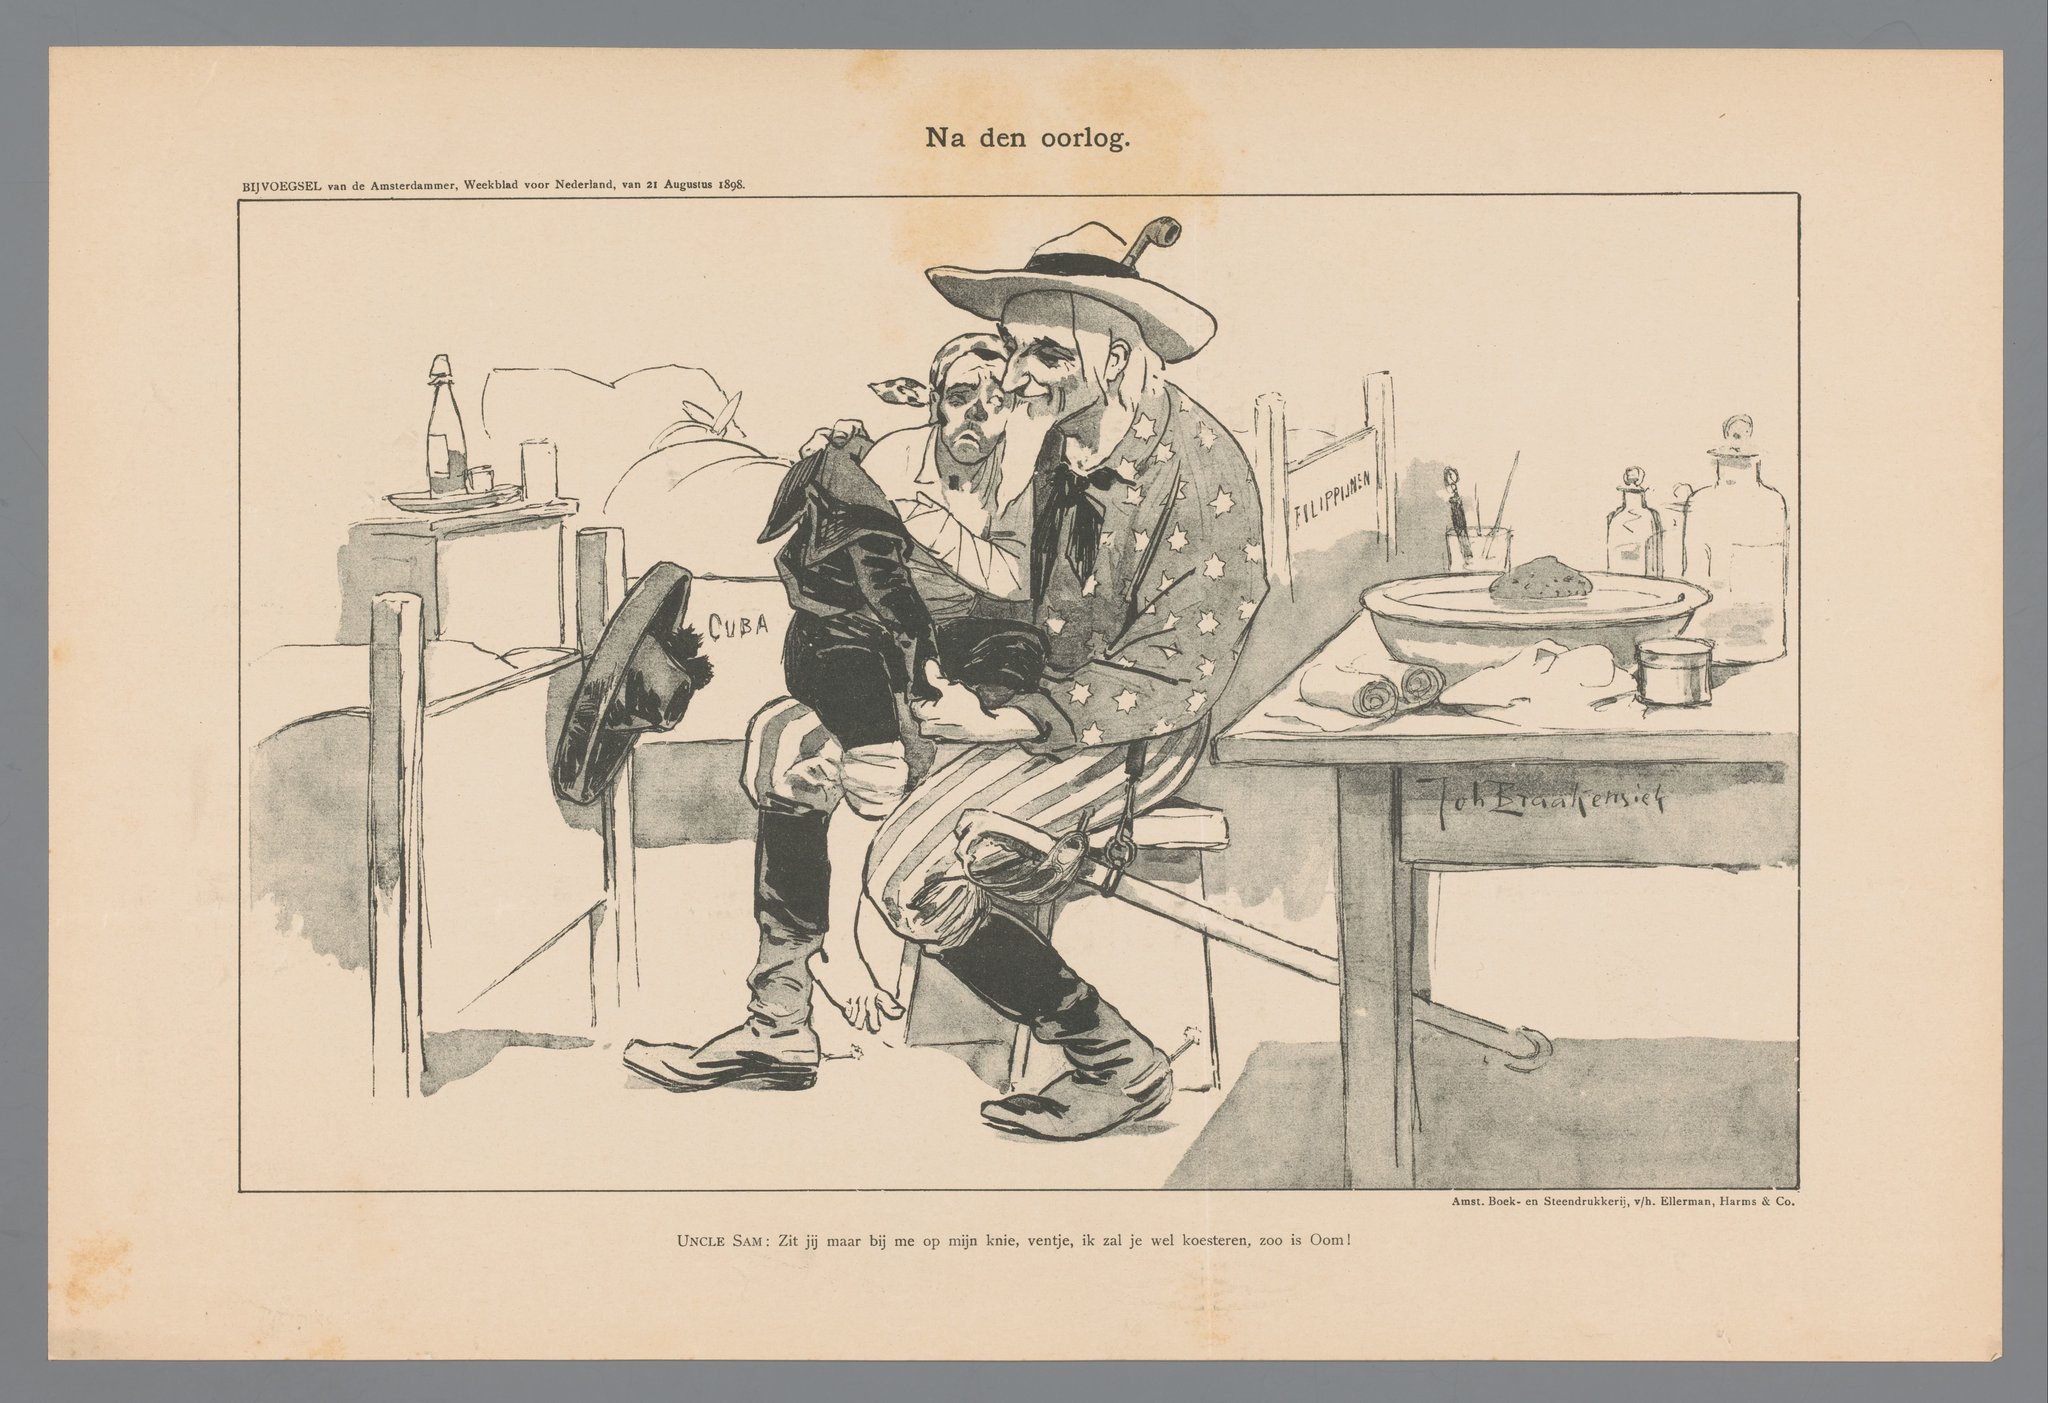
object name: cartoon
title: Na den oorlog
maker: johan braakensiek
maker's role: draughtsman, print maker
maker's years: 1858-1940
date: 1898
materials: paper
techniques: lithograph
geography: amsterdam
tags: patient, sick person, personifications of countries, nations, states, districts, etc. (+ nation; national), political caricatures and satires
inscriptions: date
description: Prent uit het bijvoegsel van: De Amsterdammer. Weekblad voor Nederland, 21 augustus 1898.